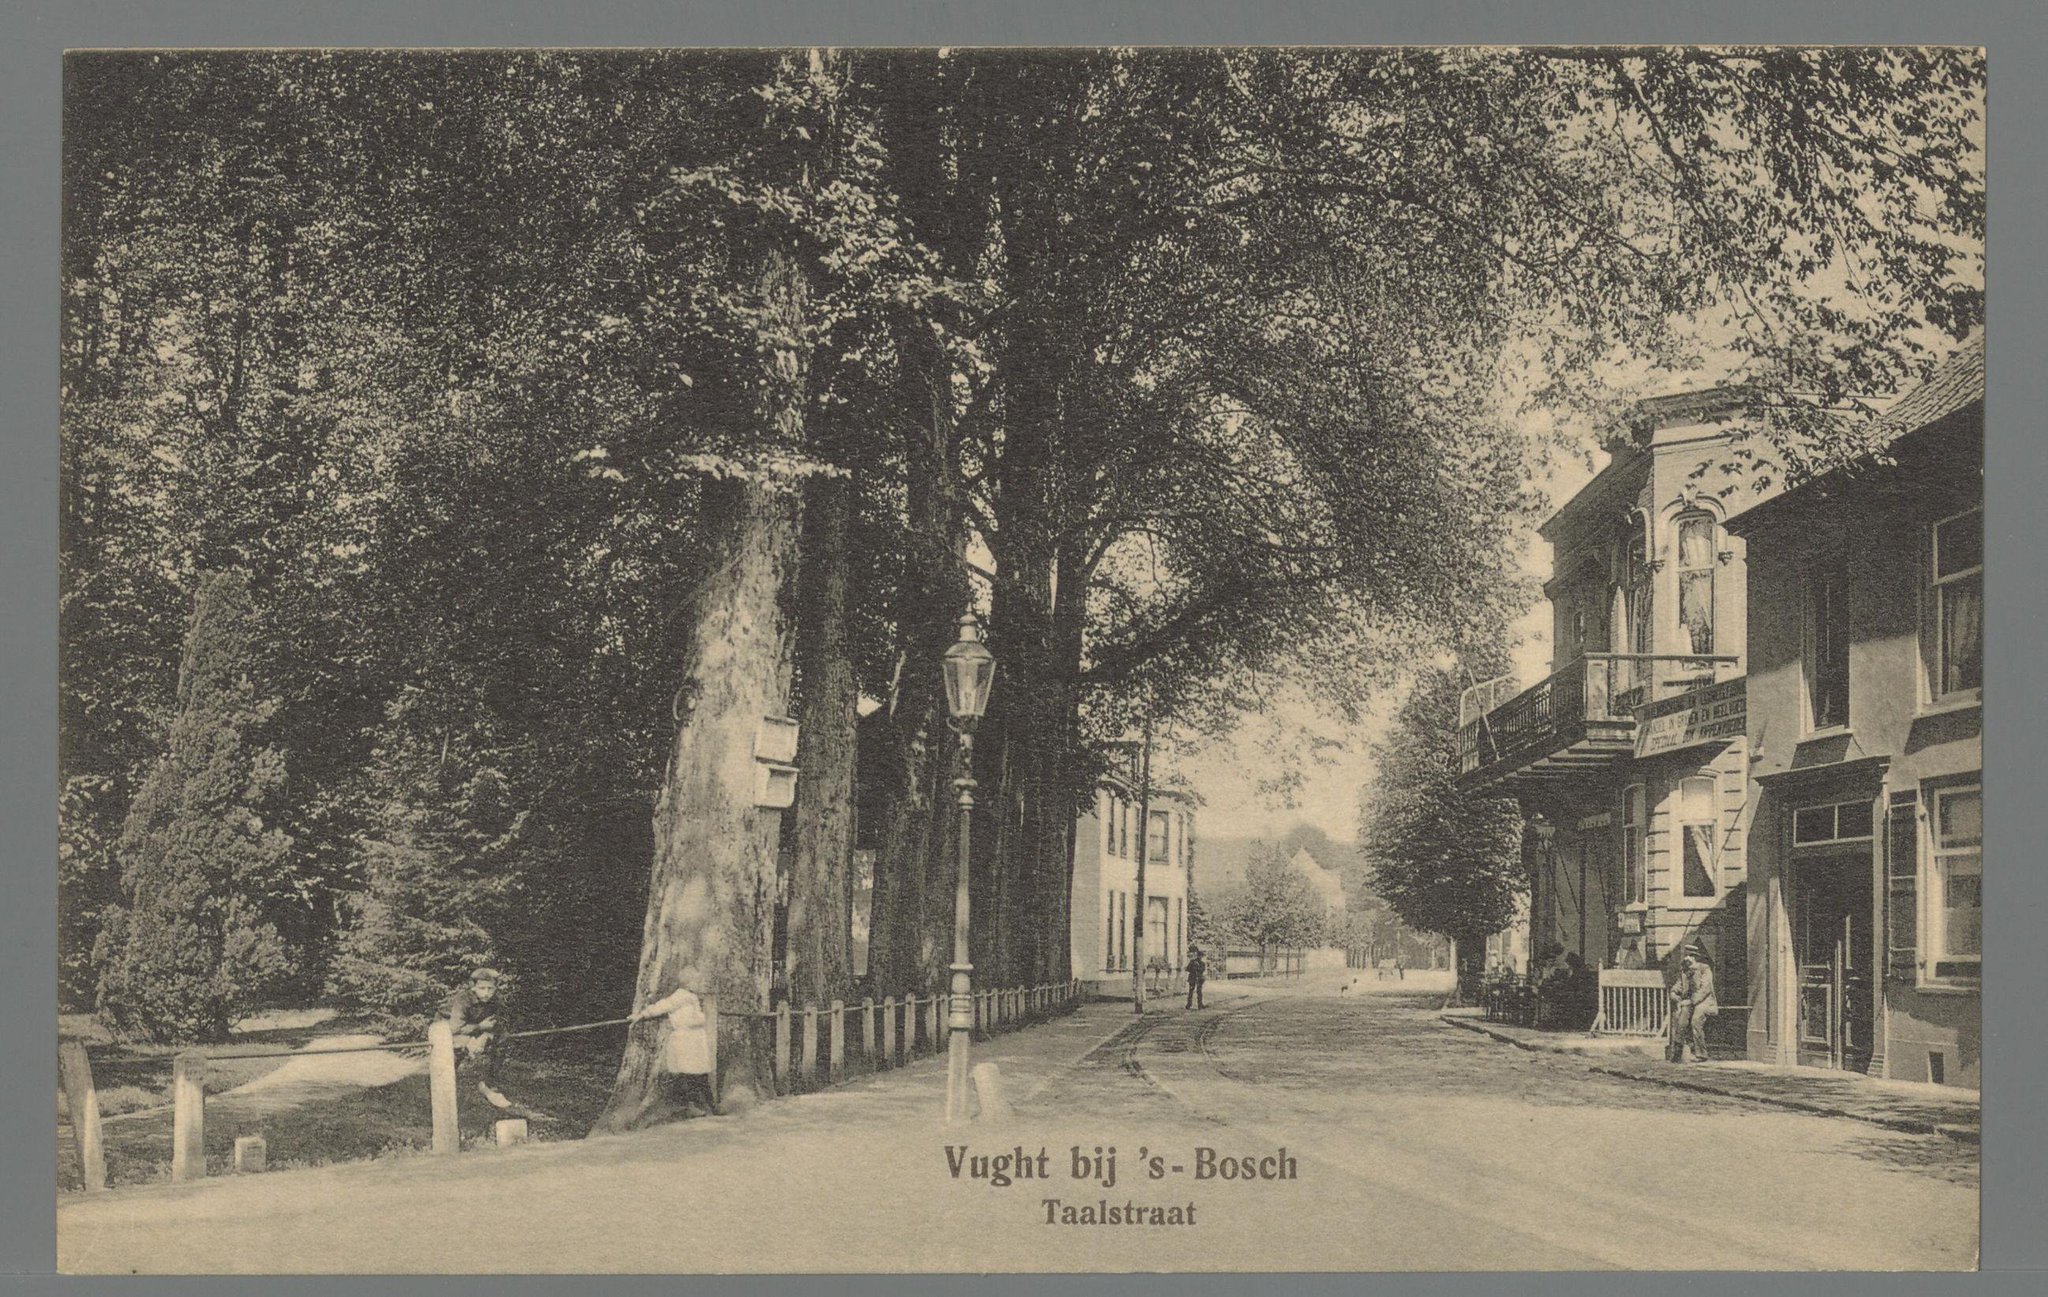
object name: photomechanical print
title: Vught bij 's-Bosch. Taalstraat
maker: Anonymous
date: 1909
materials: cardboard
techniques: photograph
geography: vught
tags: street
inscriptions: date